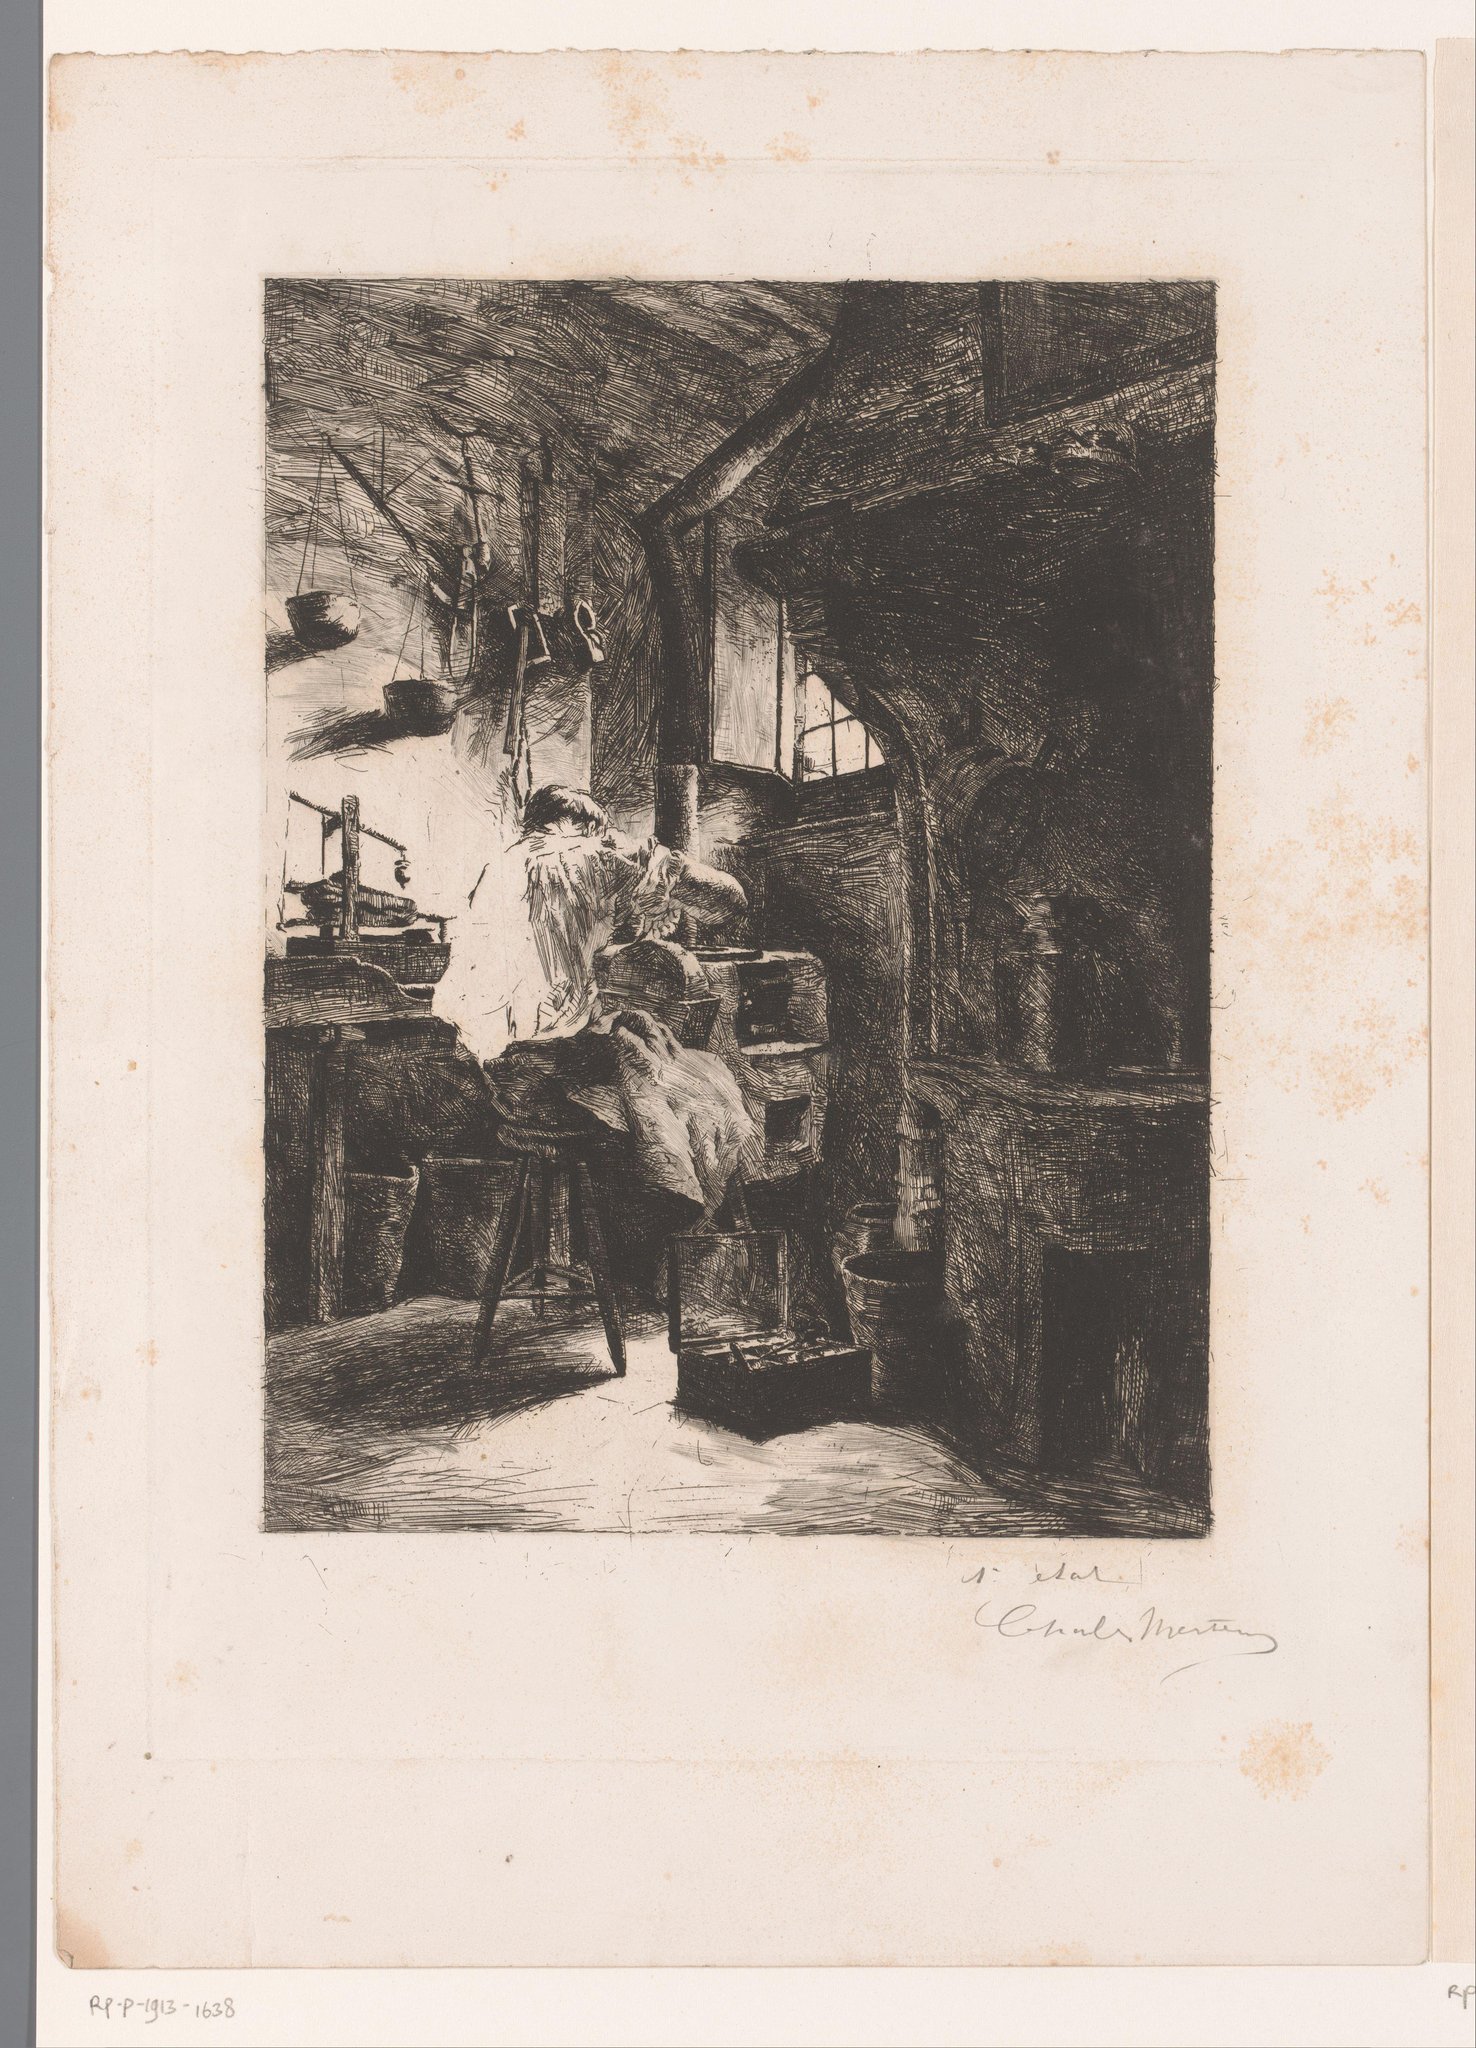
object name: print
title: Ciseleur aan het werk in een werkplaats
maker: charles mertens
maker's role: print maker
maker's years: 1865-1919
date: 1875-1913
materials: paper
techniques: etching, intaglio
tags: artist at work, in his workshop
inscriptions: collector's mark: Lugt 2228, inscription: ‘1e état’